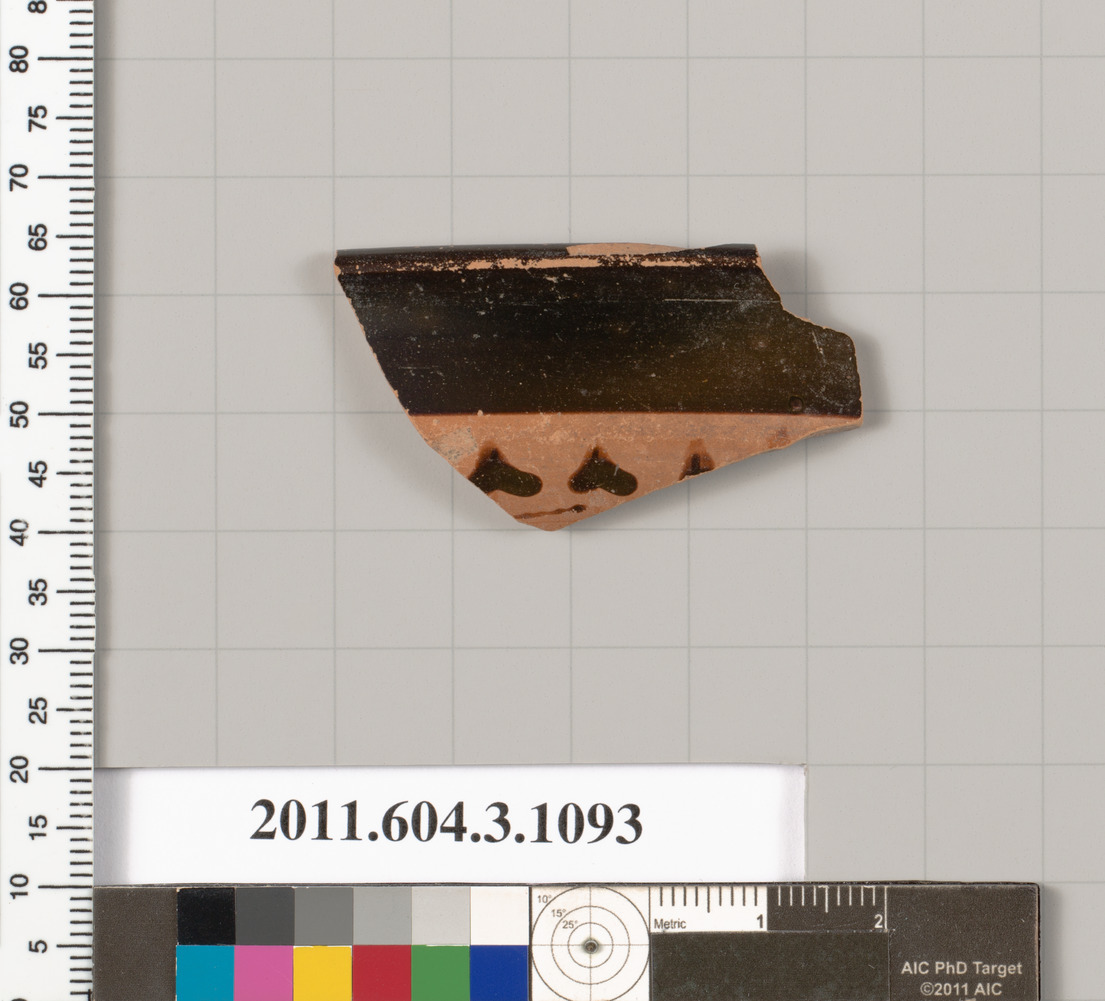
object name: mastoid fragment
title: Terracotta rim fragment of a mastoid (drinking cup with narrow base)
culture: greek, attic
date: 534-468 BCE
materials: terracotta